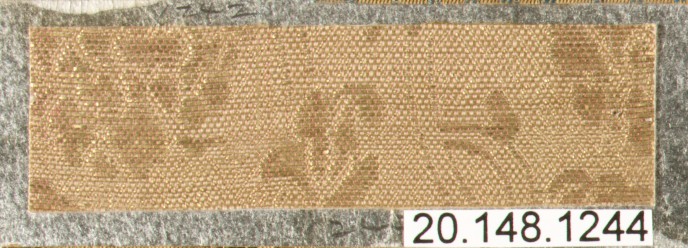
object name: piece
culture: japanese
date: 1801-1900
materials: silk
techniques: compound weave